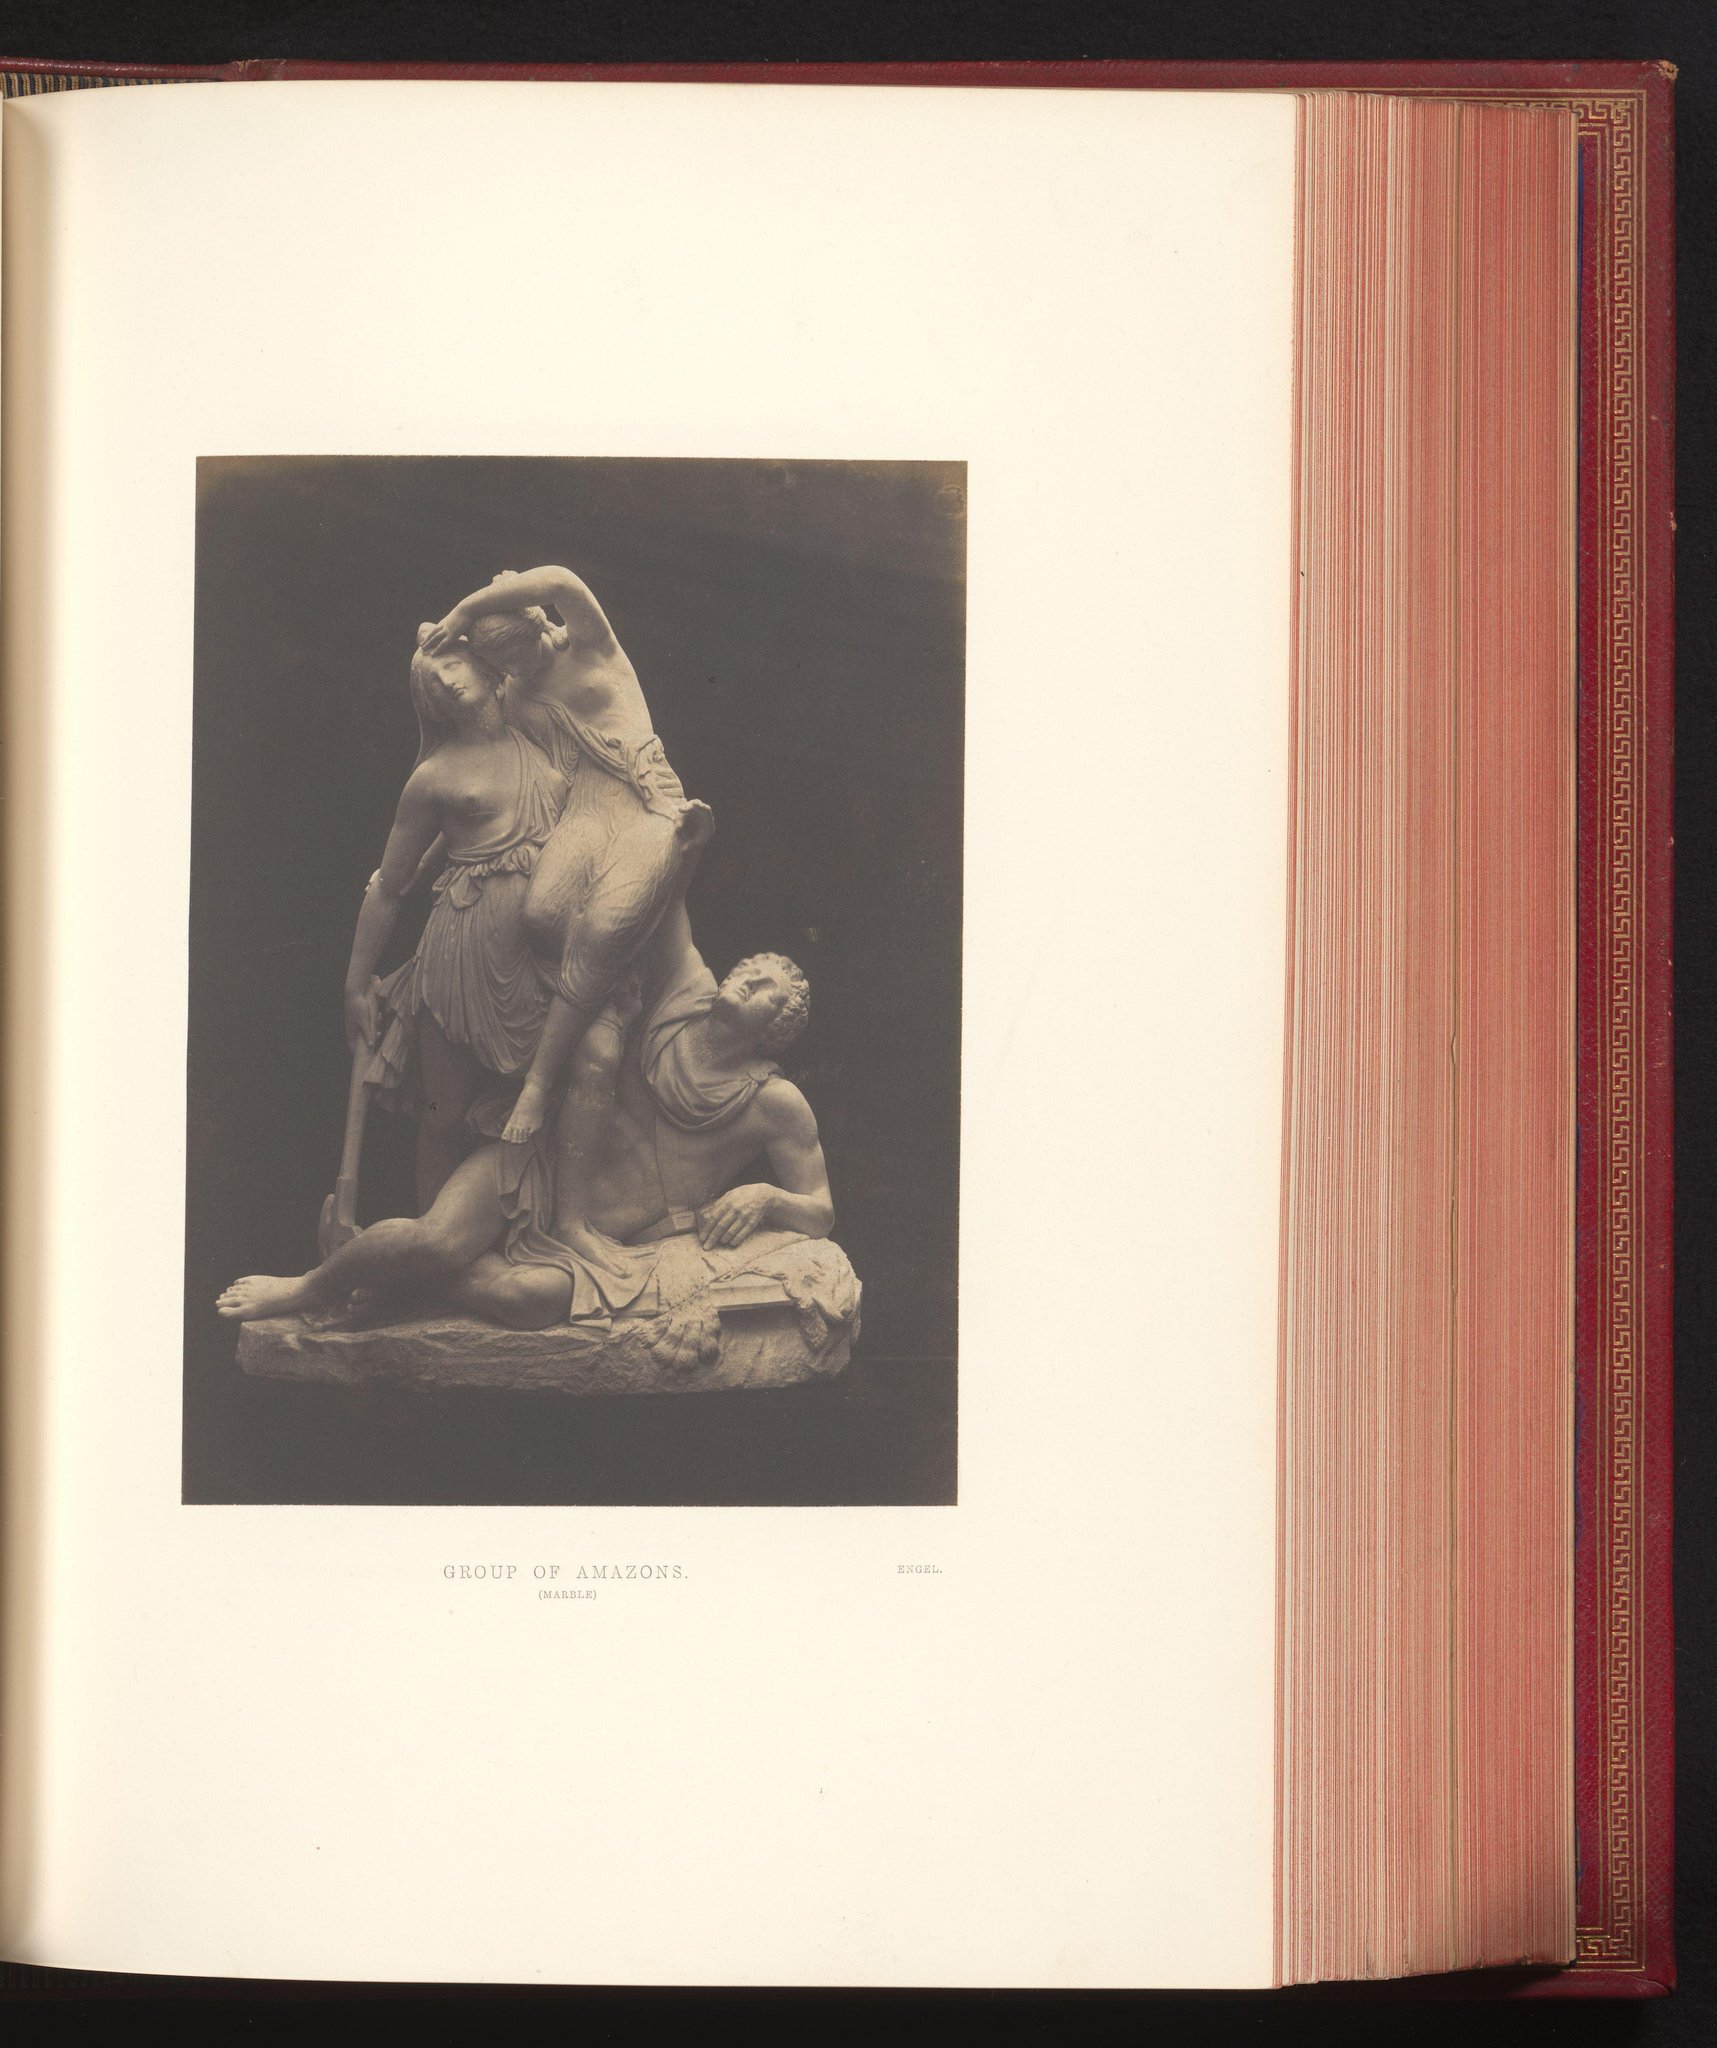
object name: page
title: Group of Amazons. (Marble) Engel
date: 1851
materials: photographic support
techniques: salted paper print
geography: london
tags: (story of) the amazons, piece of sculpture, reproduction of a piece of sculpture, london